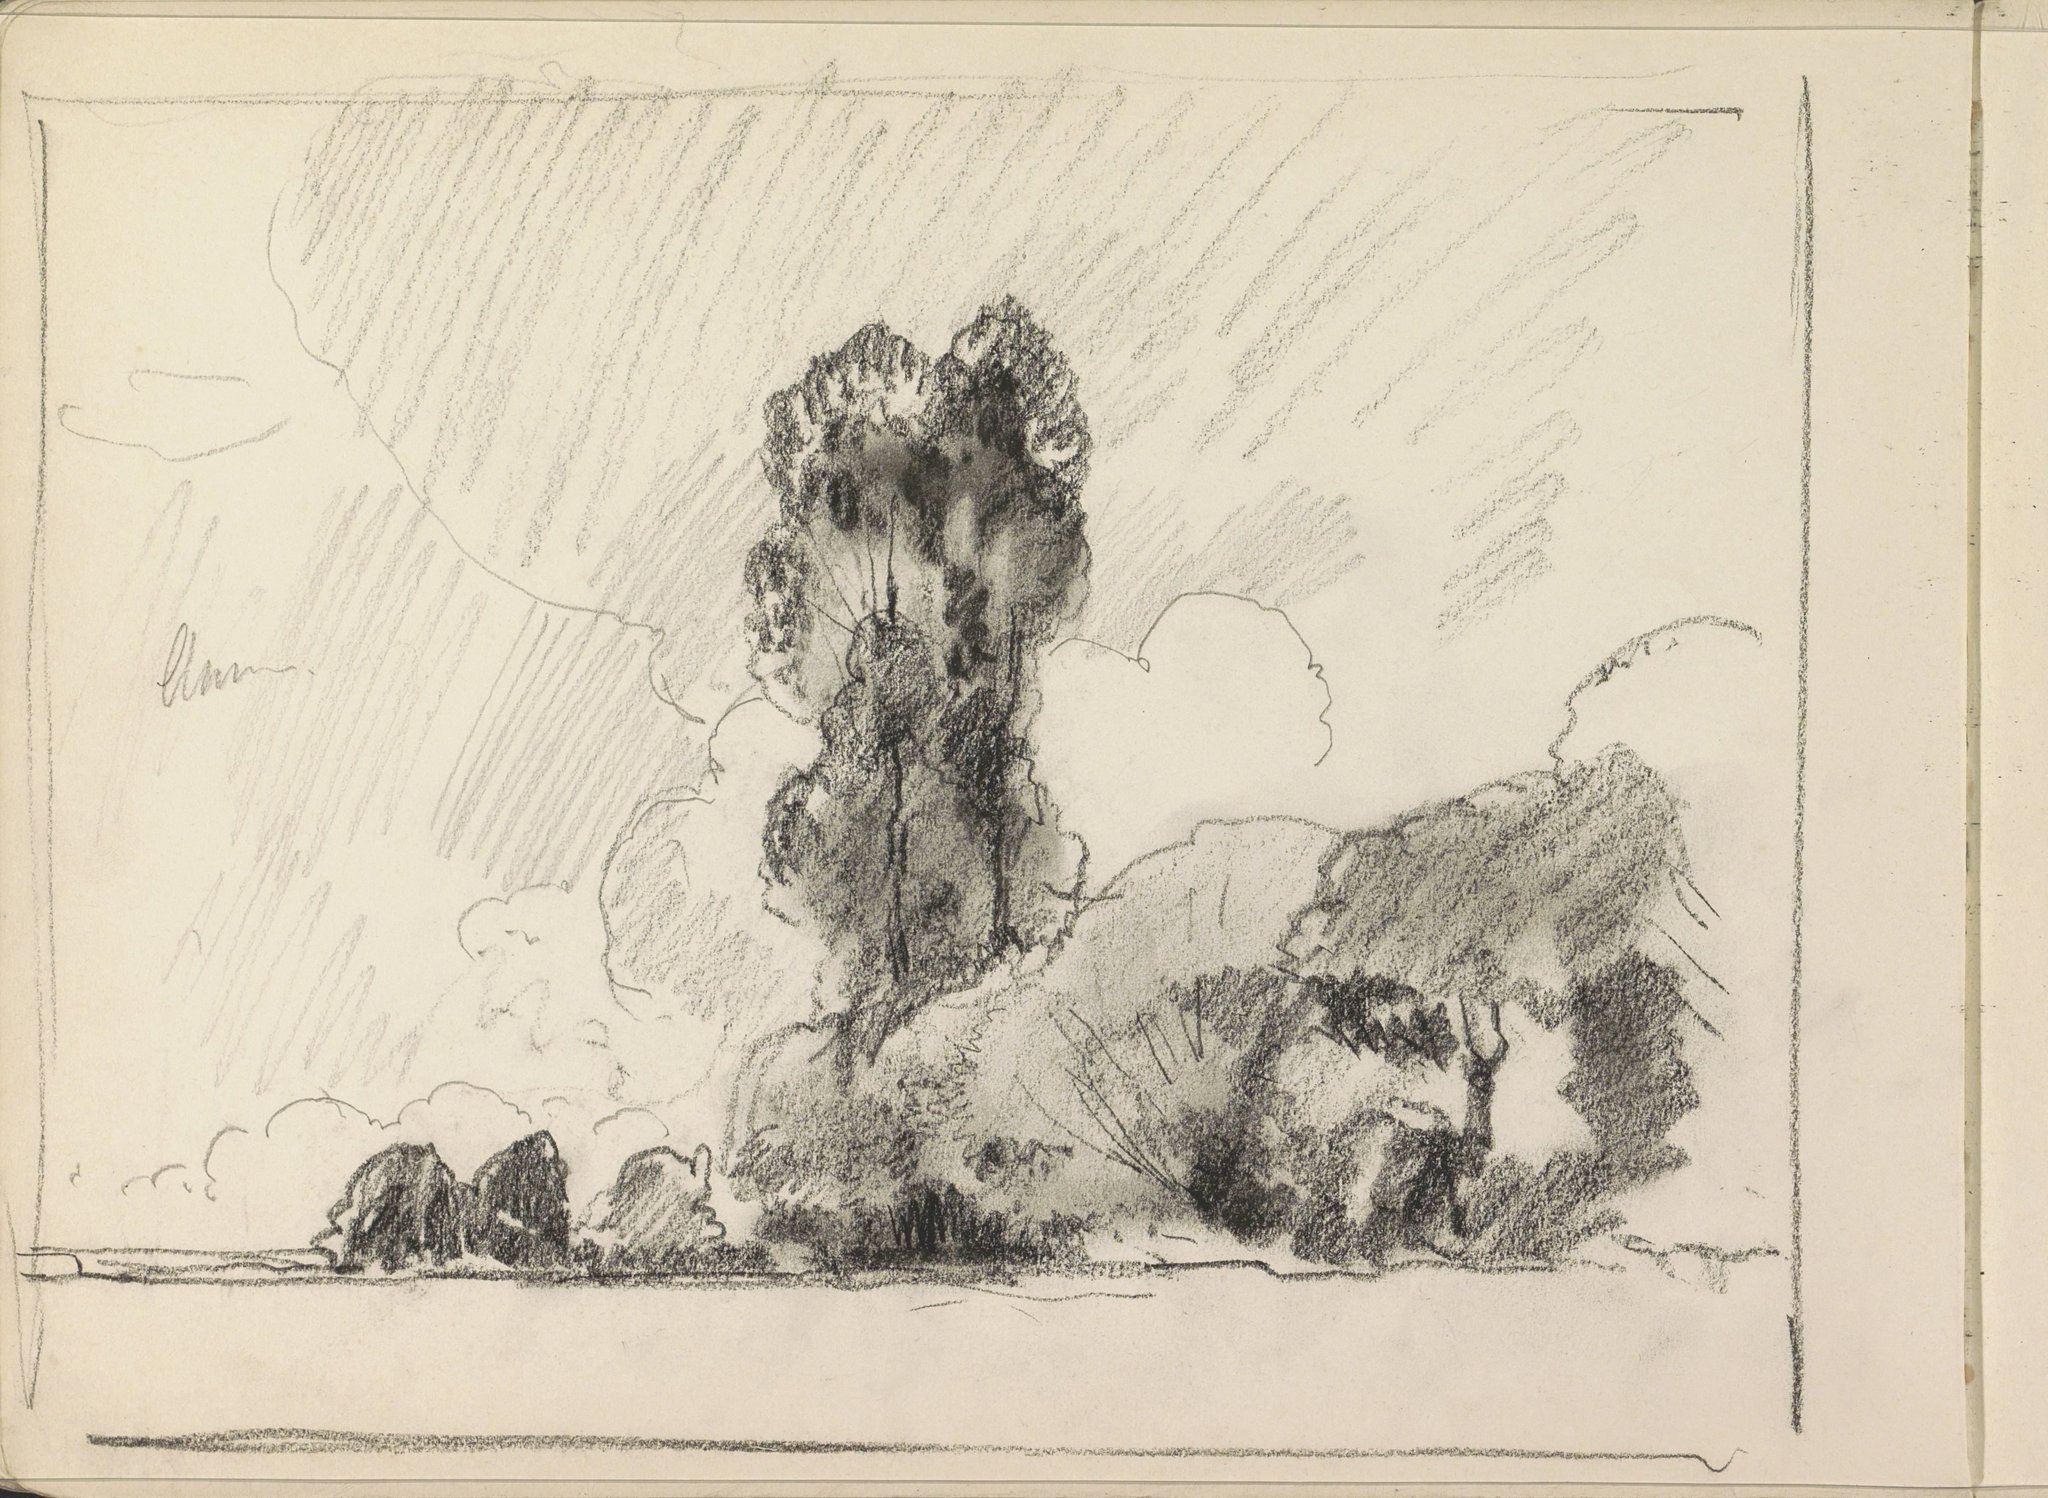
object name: sketchbook leaf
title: Landschap met bomen en struiken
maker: cornelis vreedenburgh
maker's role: draughtsman, print maker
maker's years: 1880-1946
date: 1890-1946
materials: chalk, paper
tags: landscapes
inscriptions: kleurnotitie, handgeschreven in potlood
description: Blad 15 verso uit een schetsboek met 23 bladen.